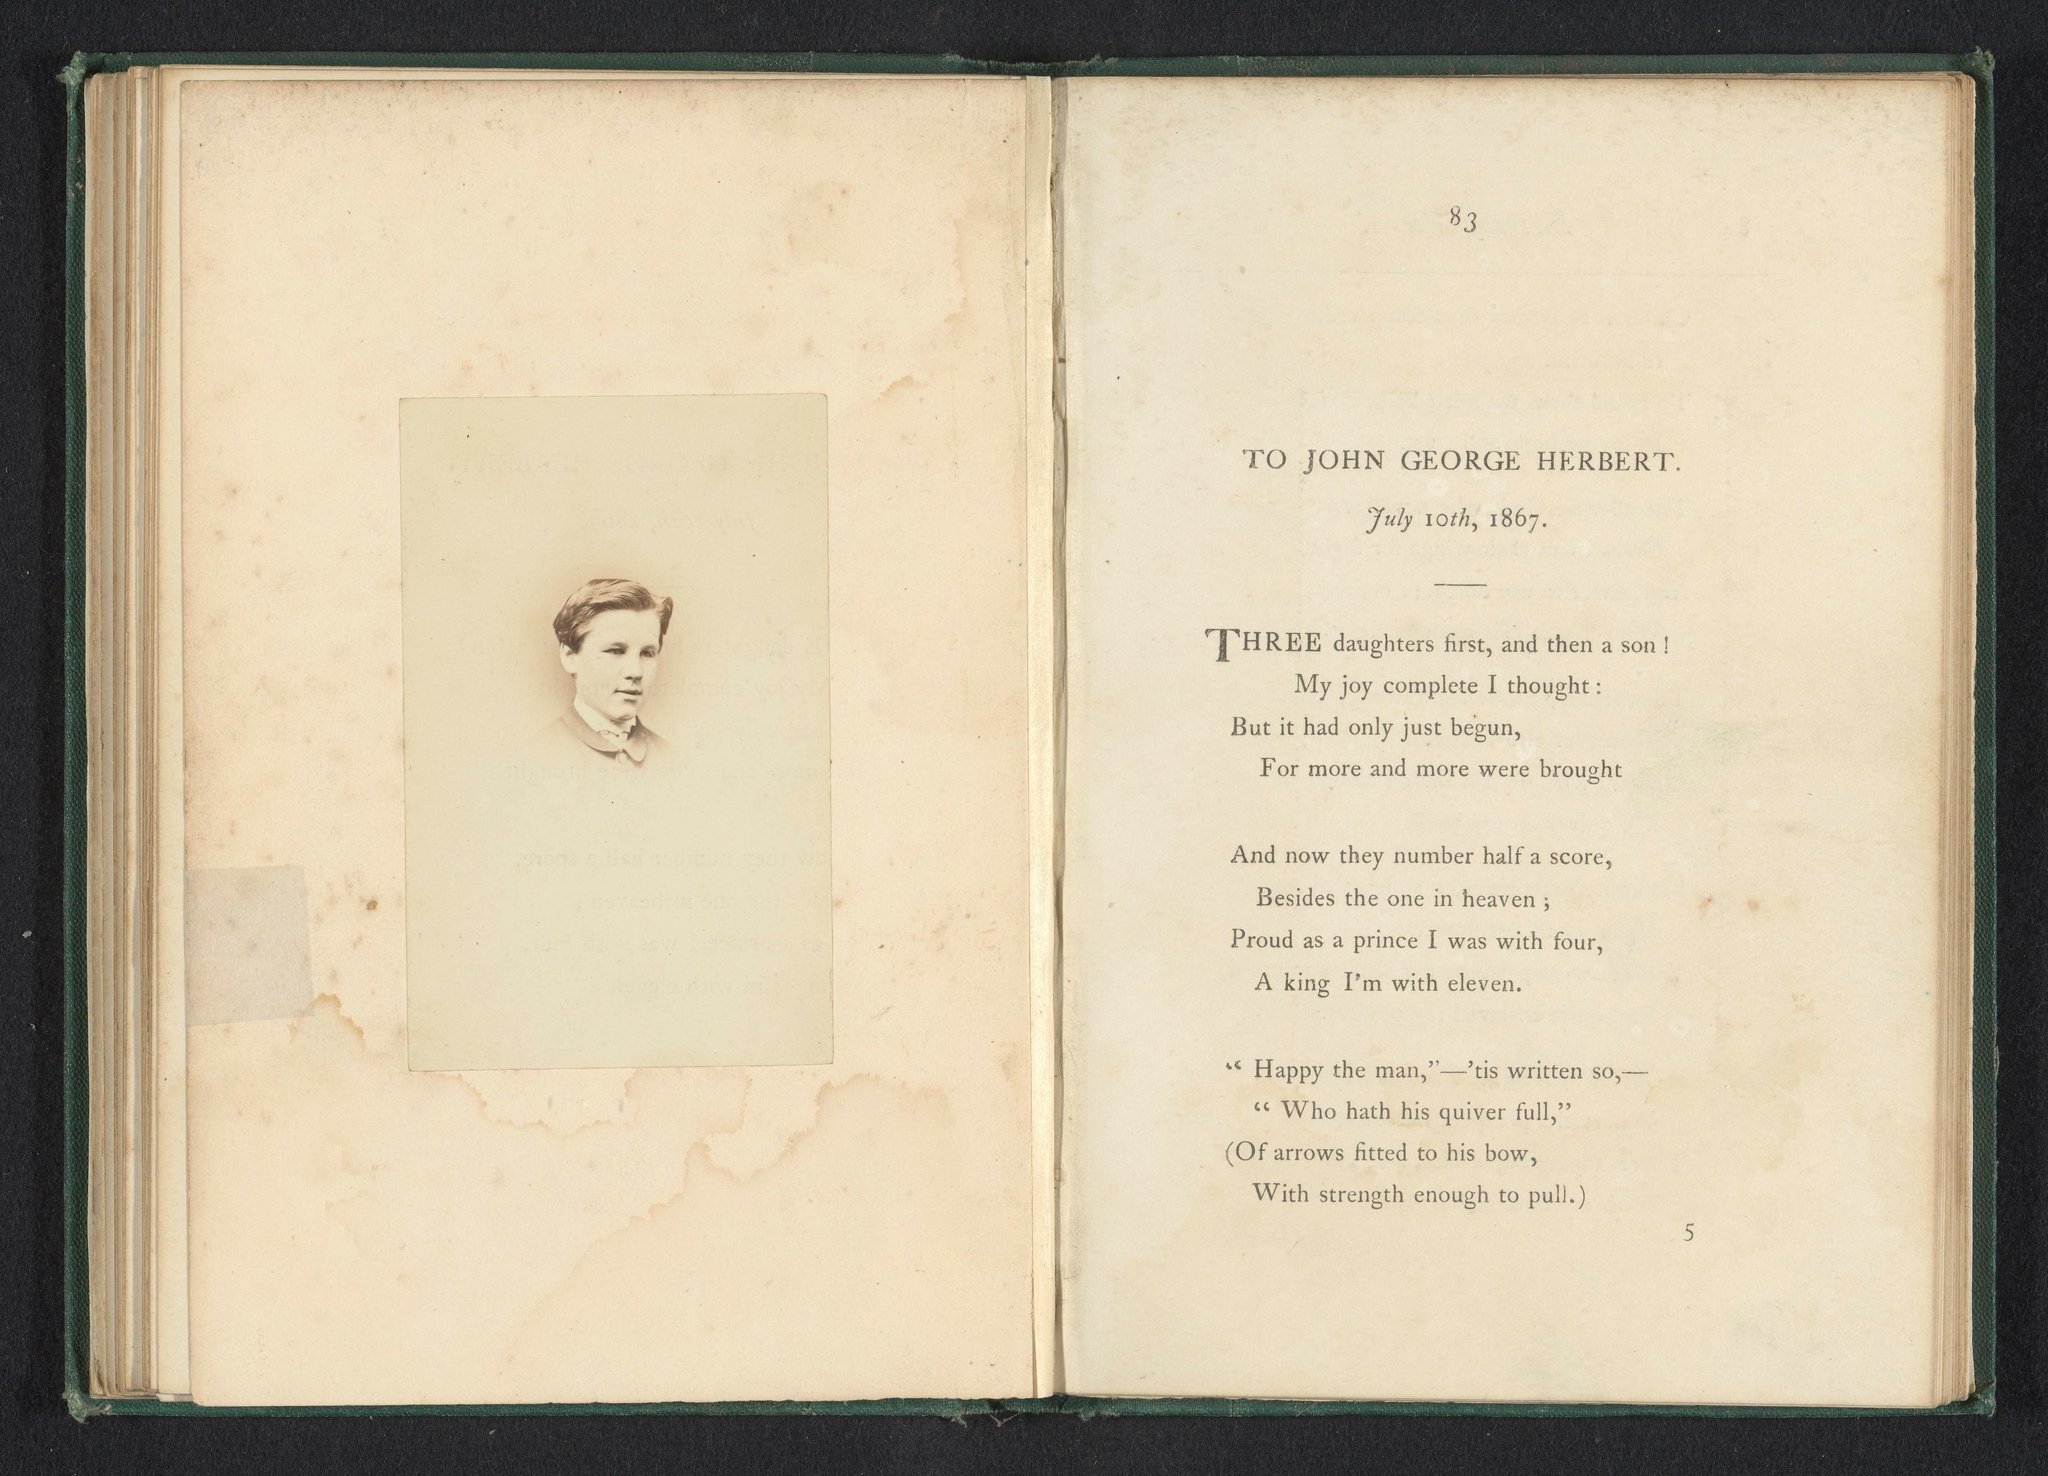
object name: photograph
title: Portret van John George Herbert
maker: Anonymous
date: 1863-1868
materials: photographic support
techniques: albumen print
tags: boy (child between toddler and youth)